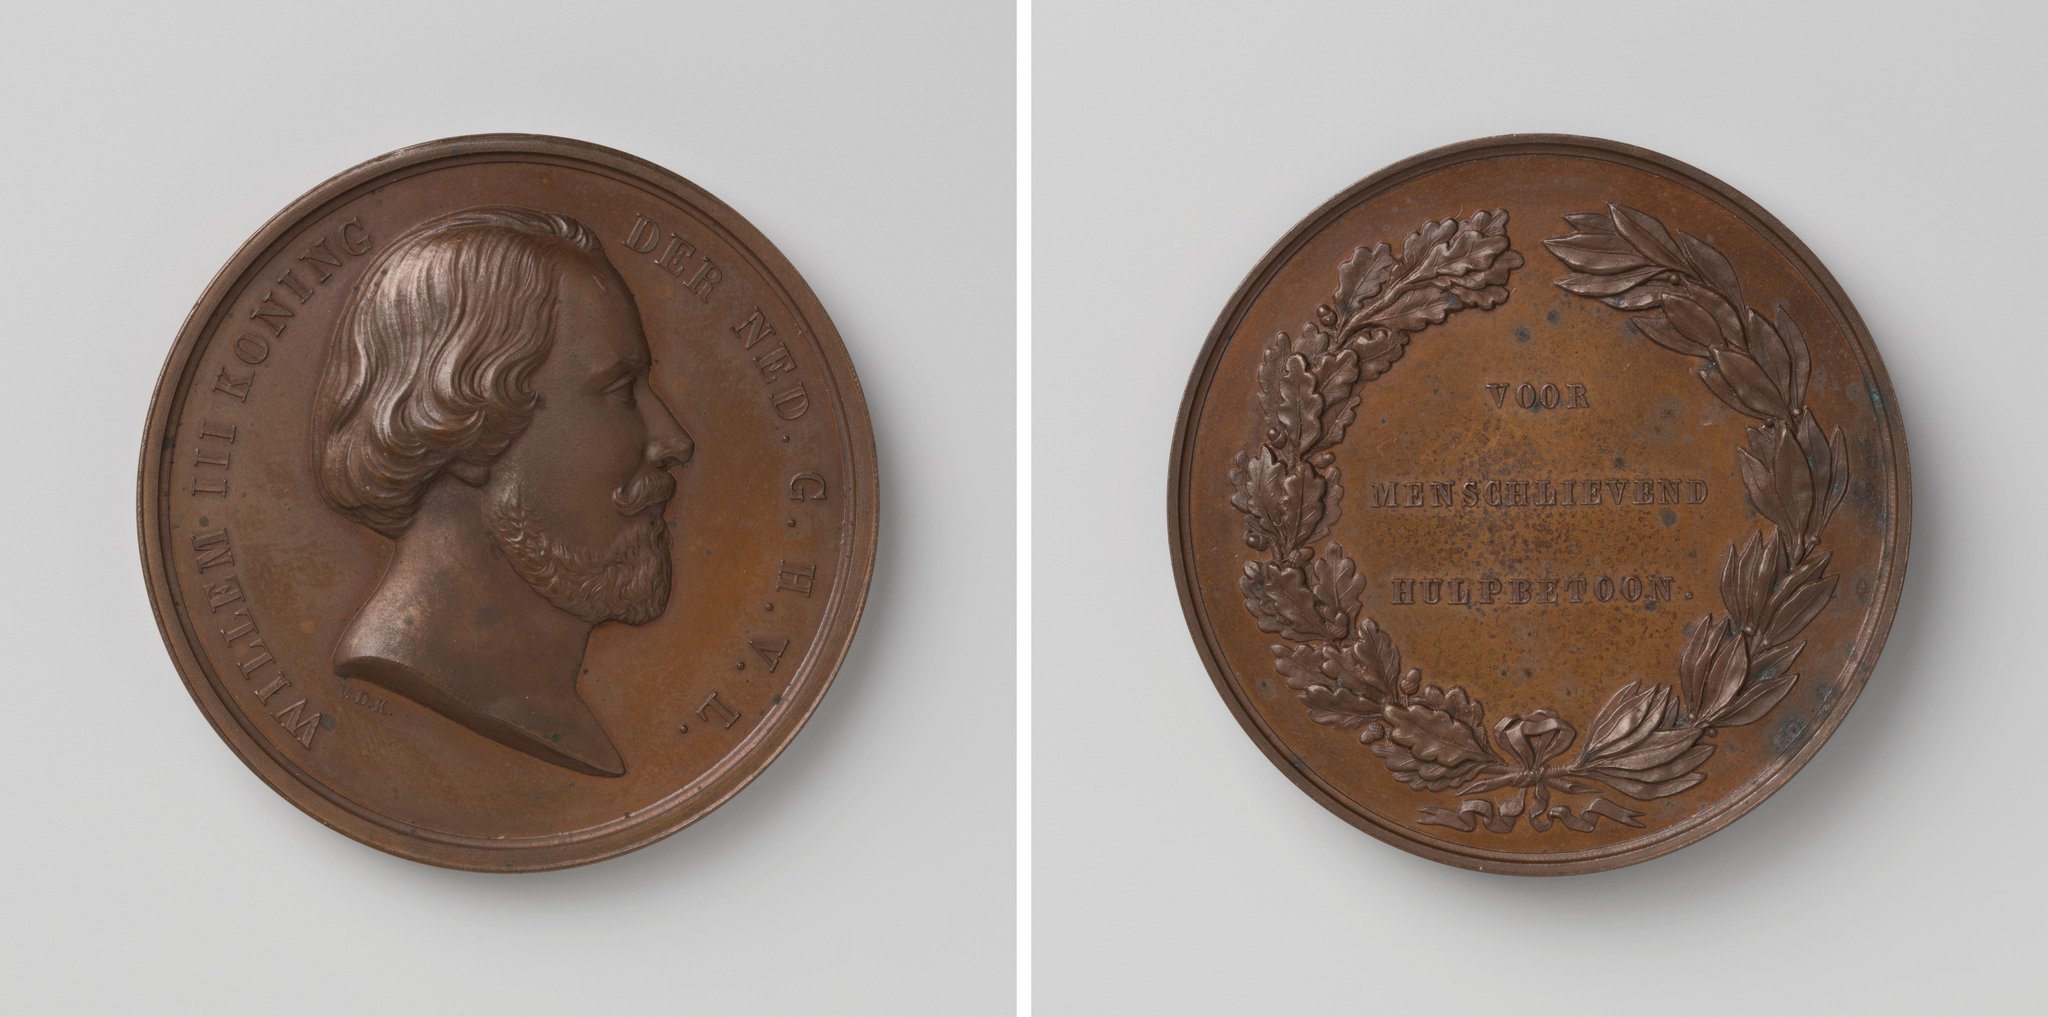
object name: honorary medal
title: Menslievend Hulpbetoon, ter ere van Willem III, koning der Nederlanden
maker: david van der kellen (1804-1879)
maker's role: die cutter, draughtsman, print maker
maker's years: 1804-1879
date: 1849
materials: bronze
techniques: striking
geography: utrecht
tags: brussels, willem iii (koning der nederlanden)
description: Bronzen penning. Voorzijde: borststuk man binnen omschrift. Keerzijde: opschrift binnen tot krans samengebonden lauwer- en eiketak